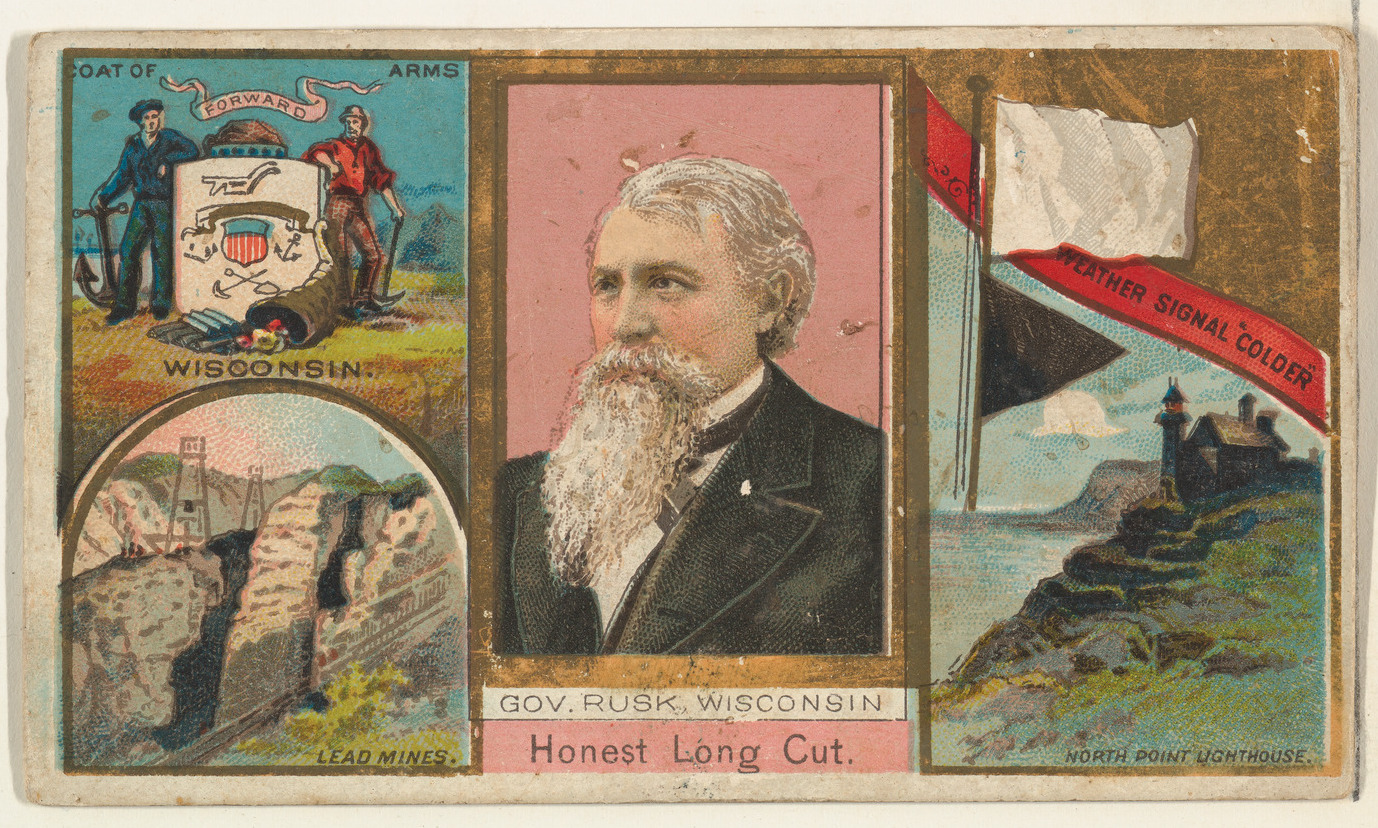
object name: print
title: Governor Rusk, Wisconsin, from "Governors, Arms, Etc." series (N133-1), issued by Duke Sons & Co.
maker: w. duke, sons & co.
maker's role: publisher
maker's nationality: american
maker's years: 1870-1920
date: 1888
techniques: color lithograph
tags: men,profiles,coat of arms